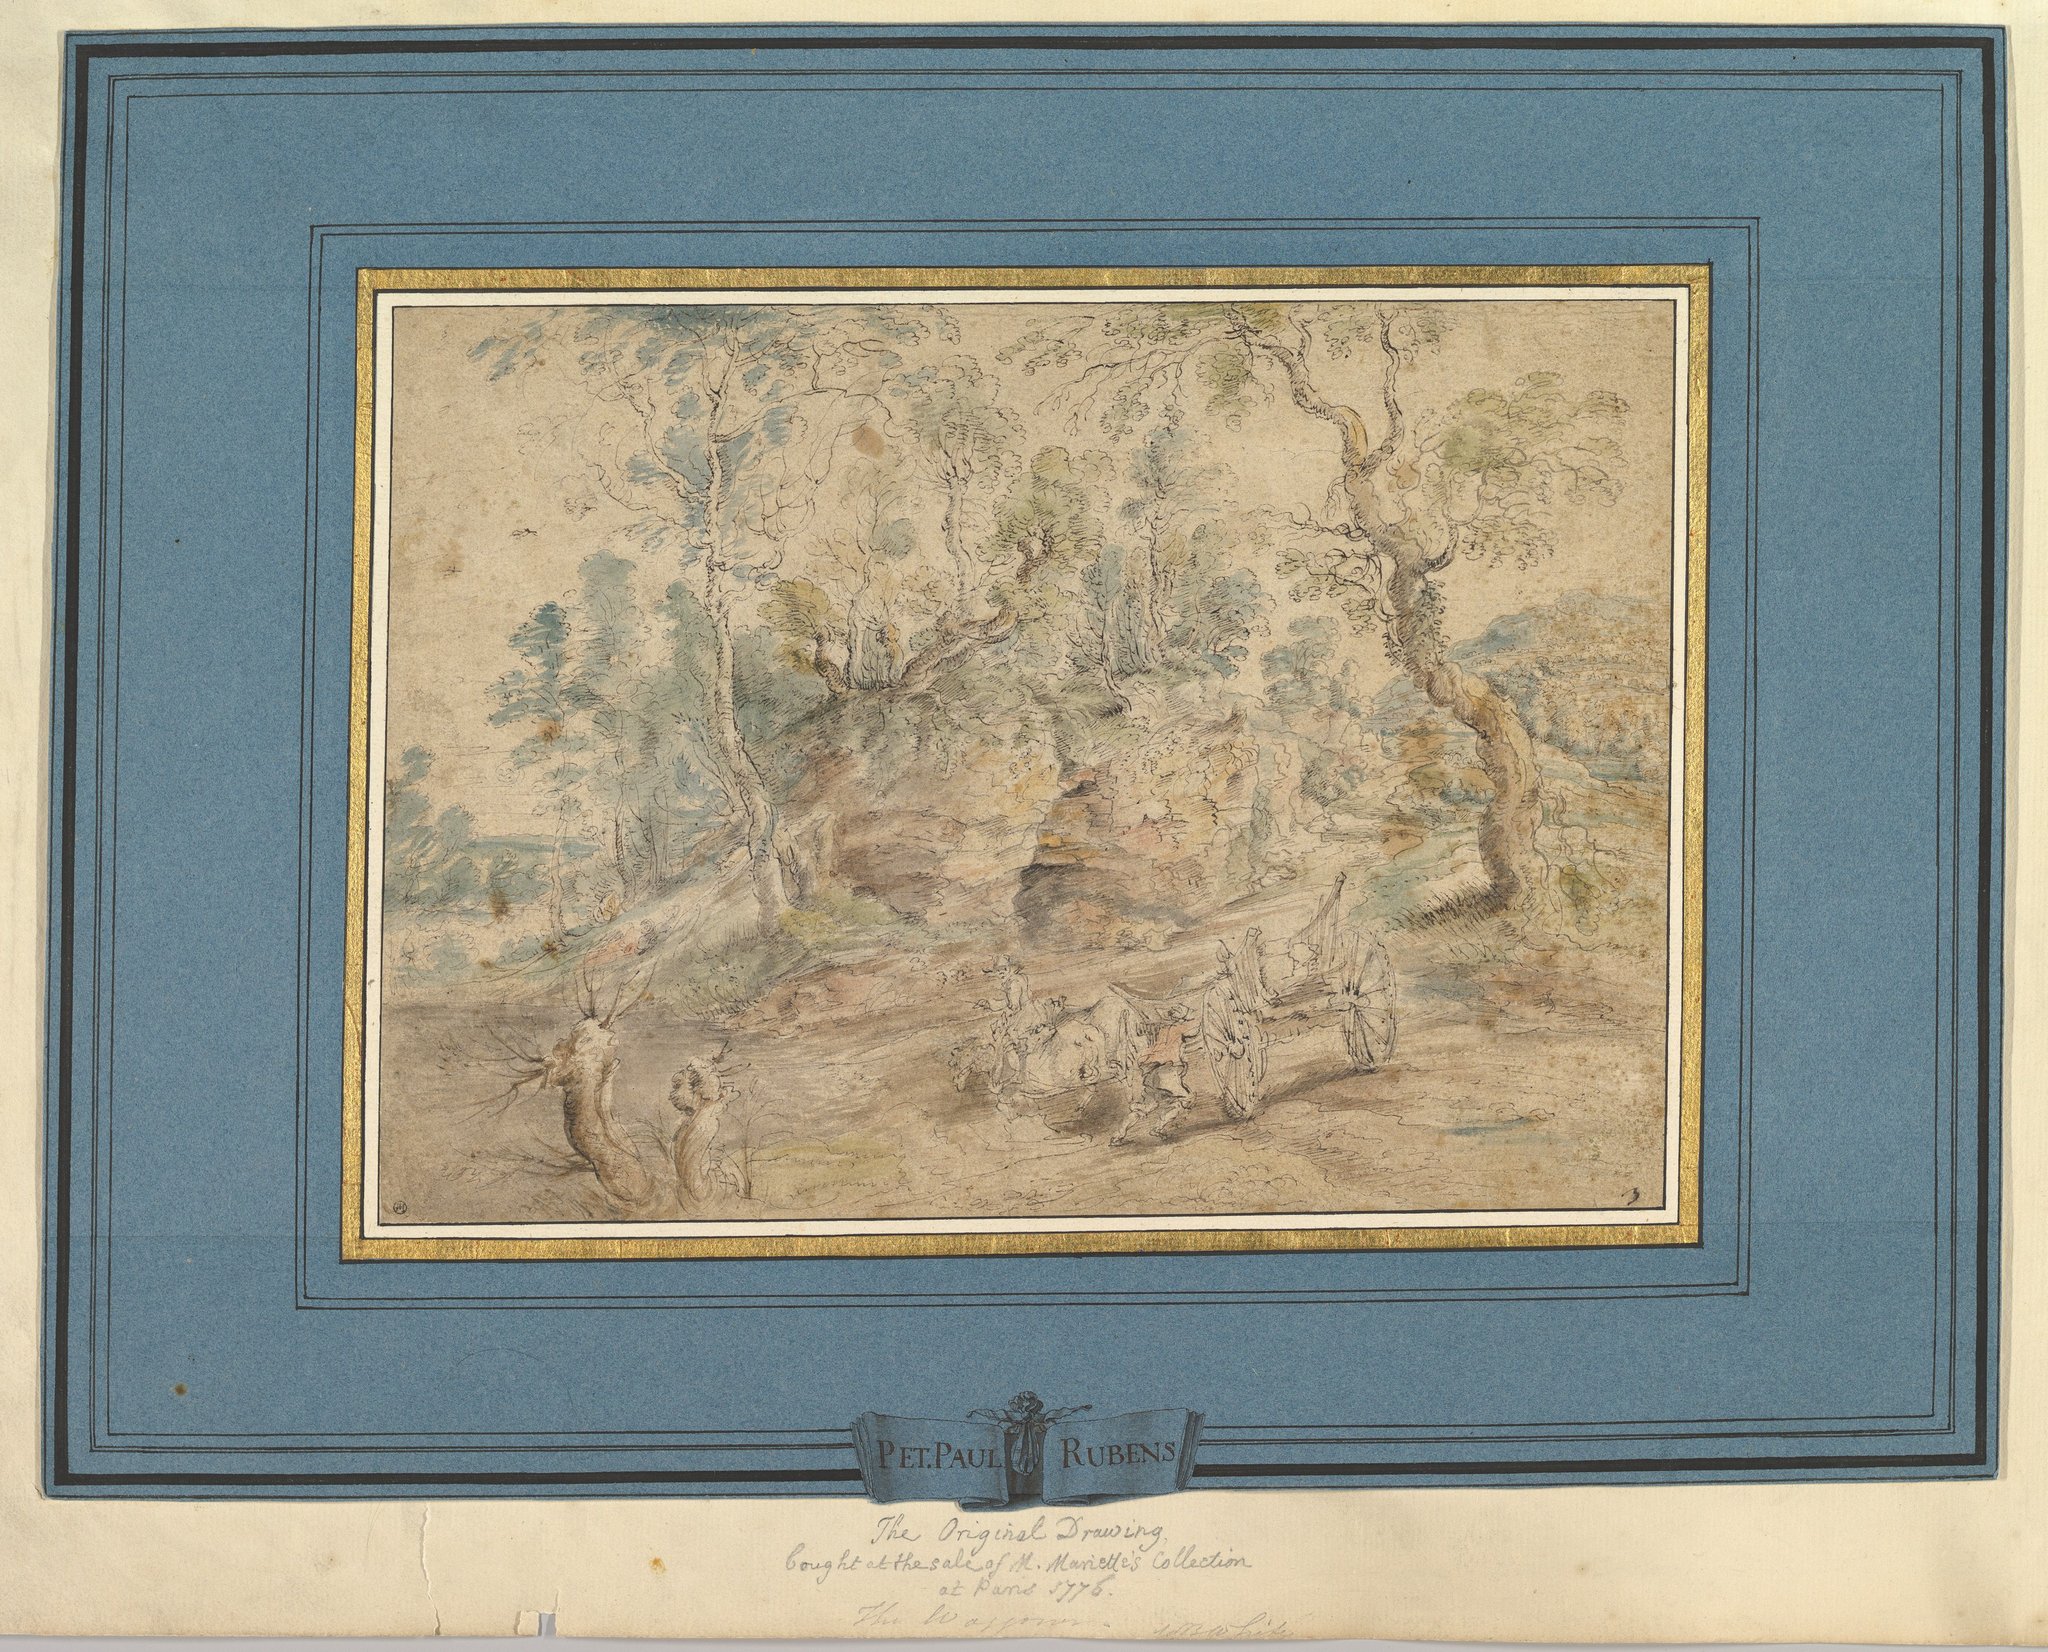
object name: drawing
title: The Wagonner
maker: lodewijk de vadder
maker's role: artist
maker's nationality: flemish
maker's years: 1605-1655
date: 1620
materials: graphite, ink, watercolor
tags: trees,carriages